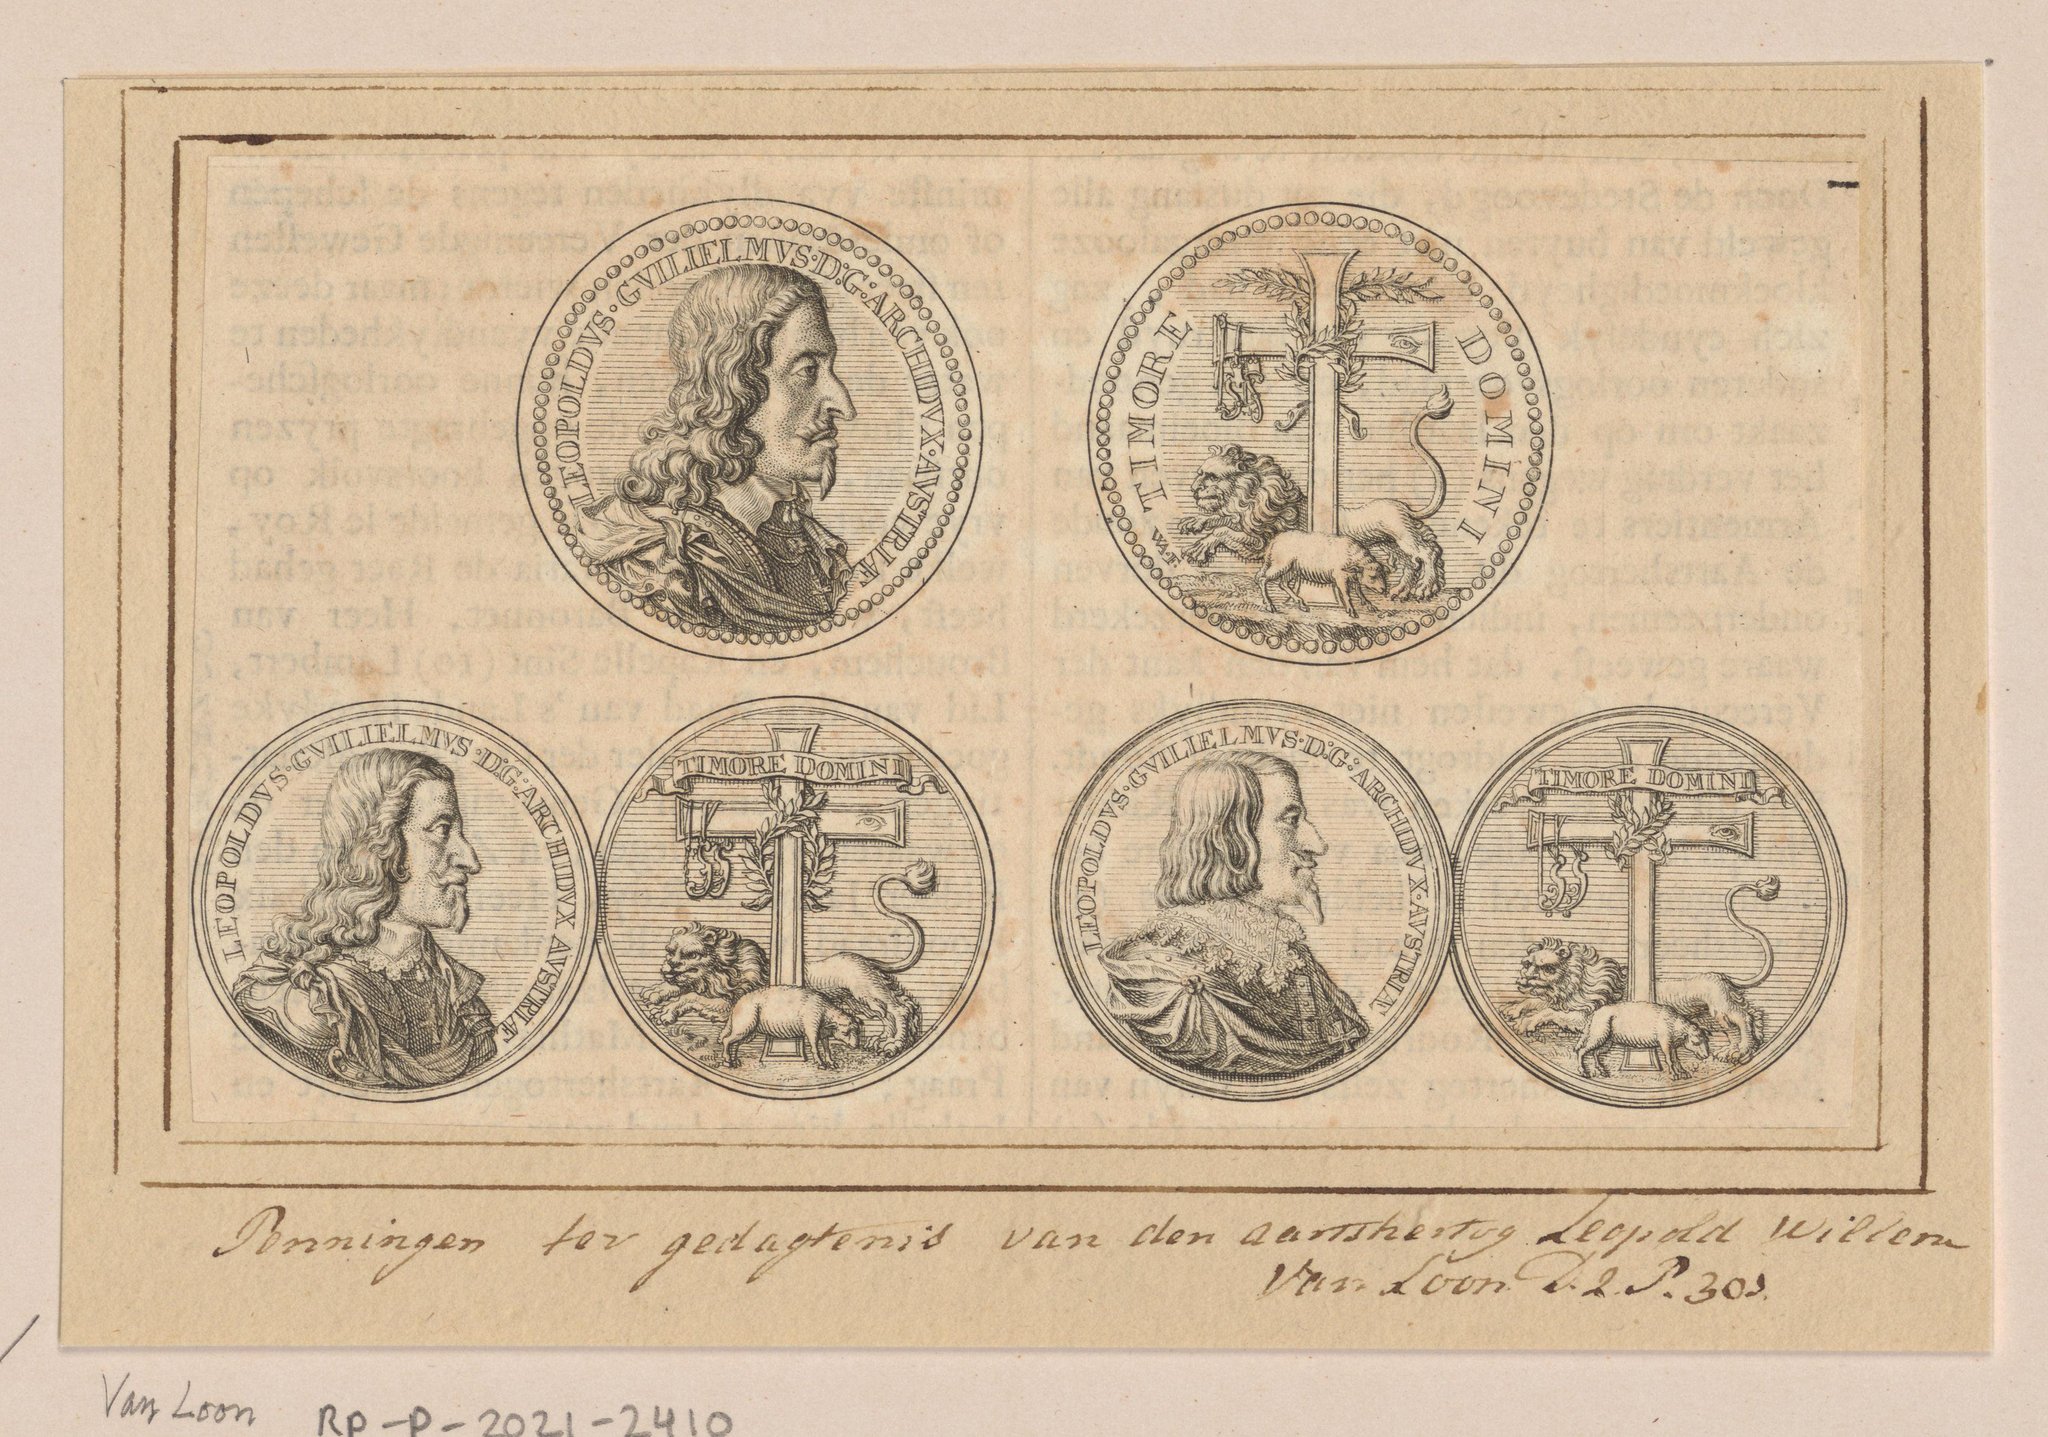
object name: print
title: Voor- en achterzijde van drie penningen met het portret van Leopold Willem van Oostenrijk en zijn motto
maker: Anonymous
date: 1726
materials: paper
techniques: etching, letterpress printing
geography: northern netherlands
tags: leopold willem van oostenrijk (landvoogd der zuidelijke nederlanden), historical persons, armorial bearing, heraldry (...) - device, motto, coin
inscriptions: inscription: ‘Penningen ter gedagtenis van den aartshertog Leopold Willem/ Van Loon D.2 P. 301.’, monogram: ‘WA.F.’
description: Prent uit: Loon, Gerard van. Beschryving der Nederlandsche historipenningen (...). Den Haag: Christiaan van Lom et al., 1726, dl. 2, p. 301.